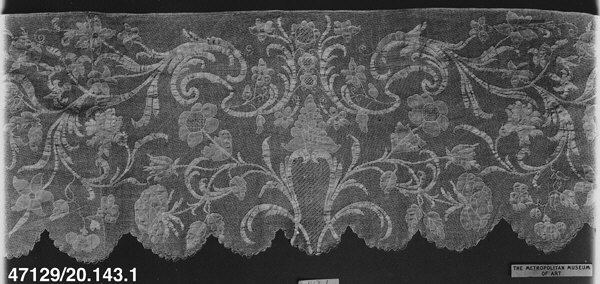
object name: flounce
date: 1701-1800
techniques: embroidery